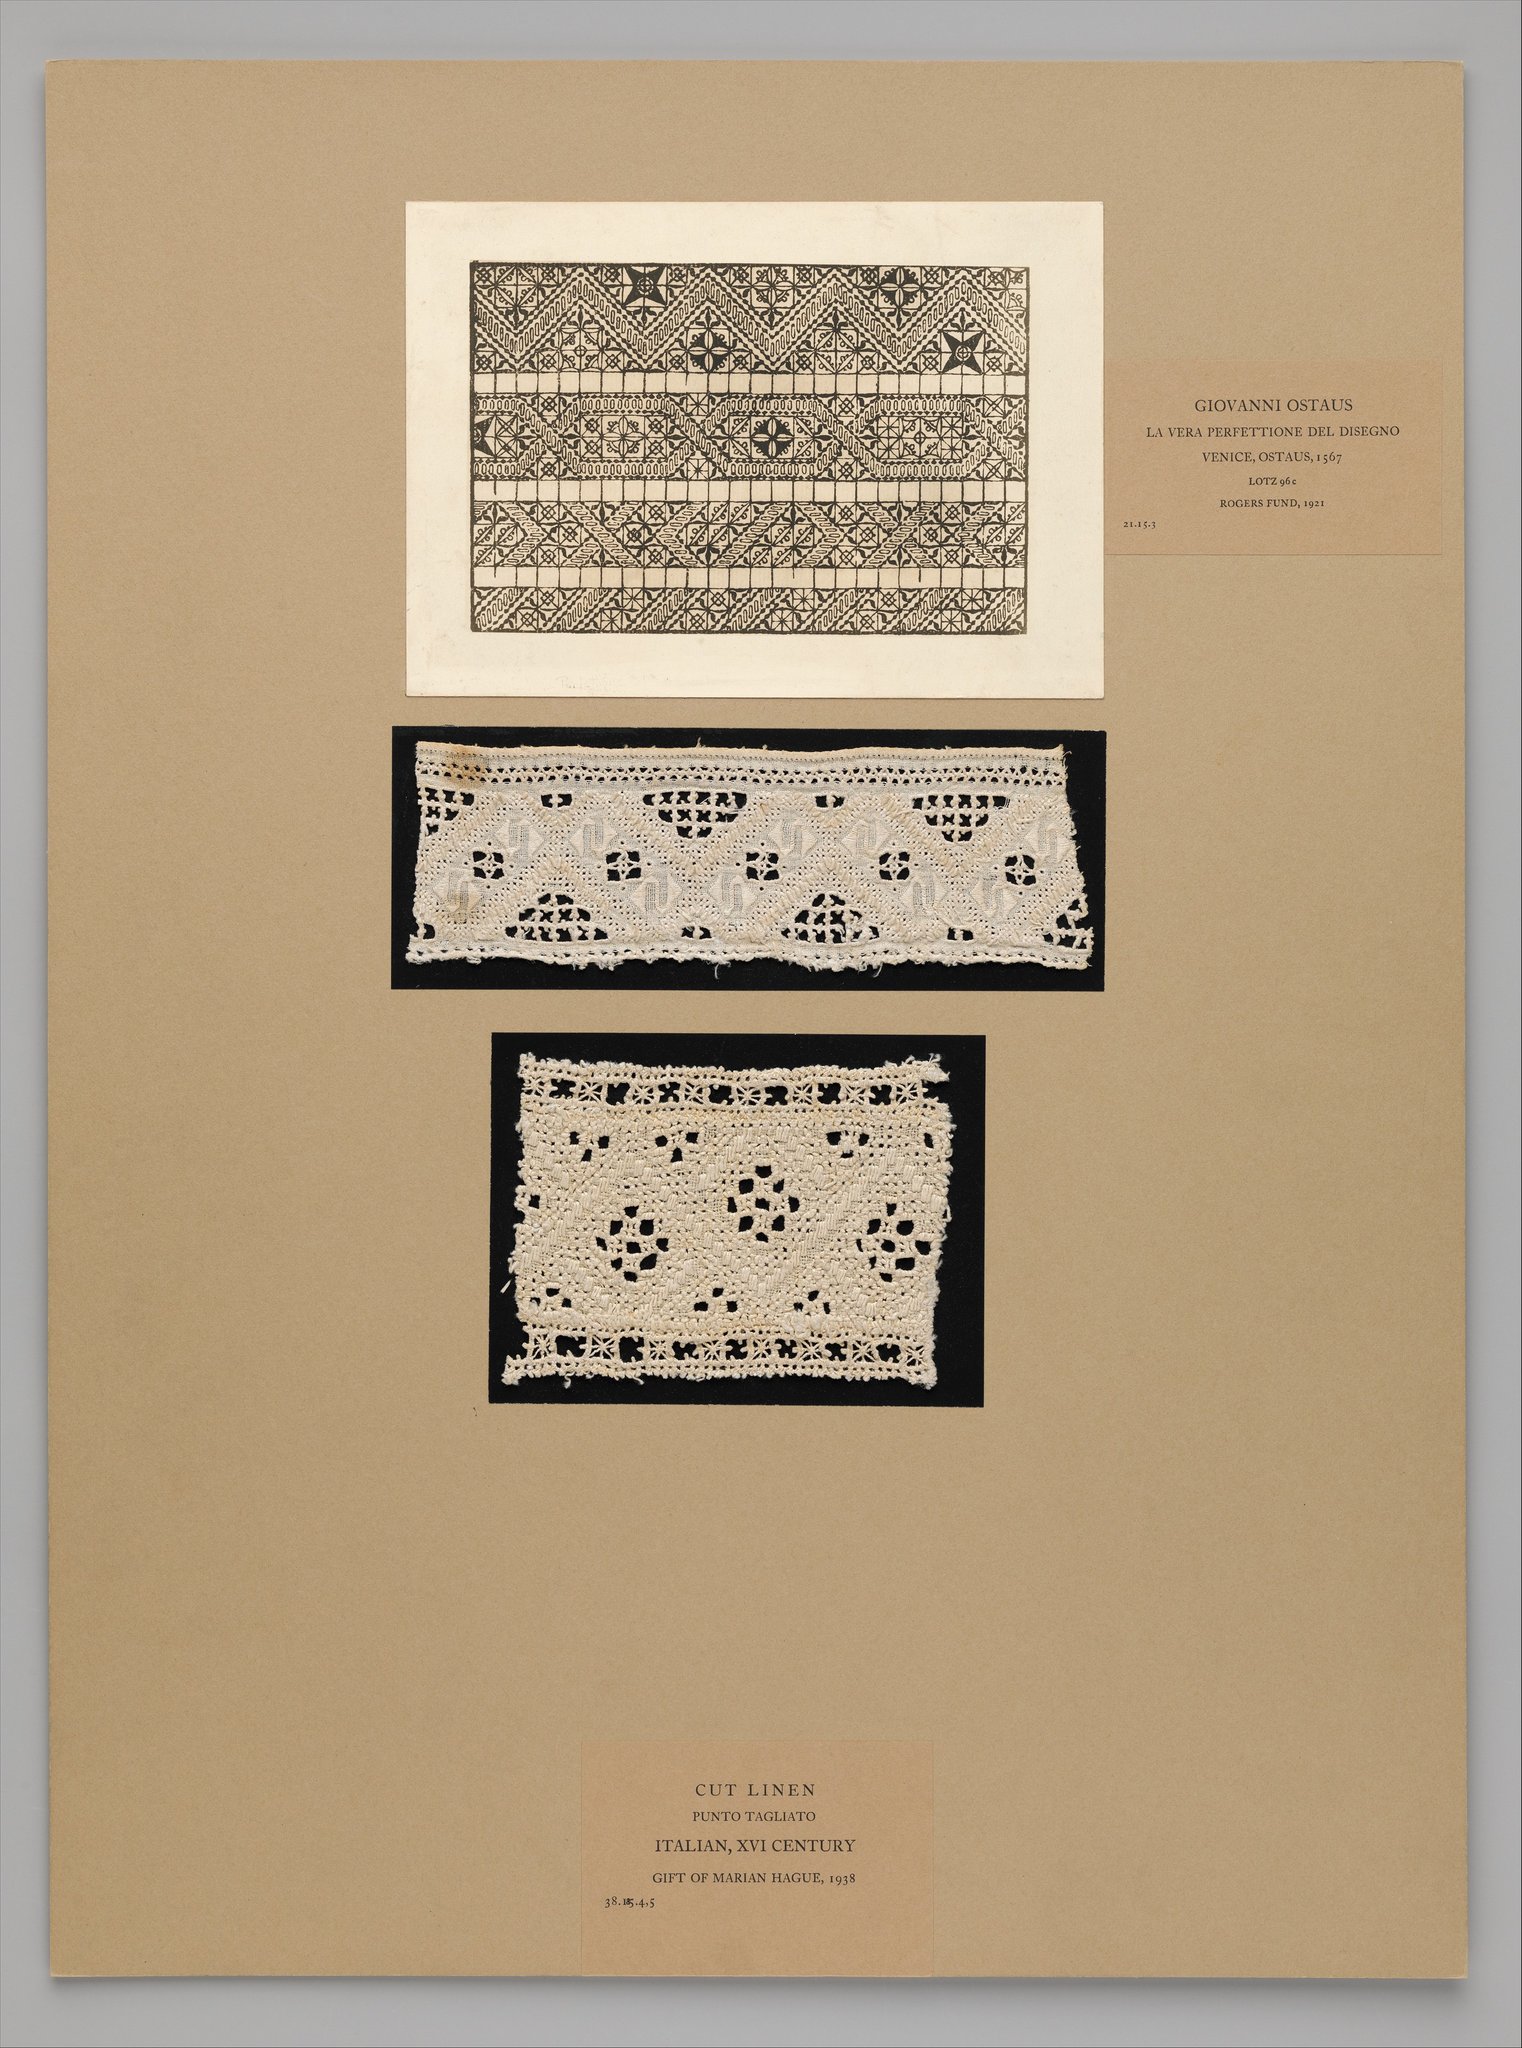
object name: insertion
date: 1501-1600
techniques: lace